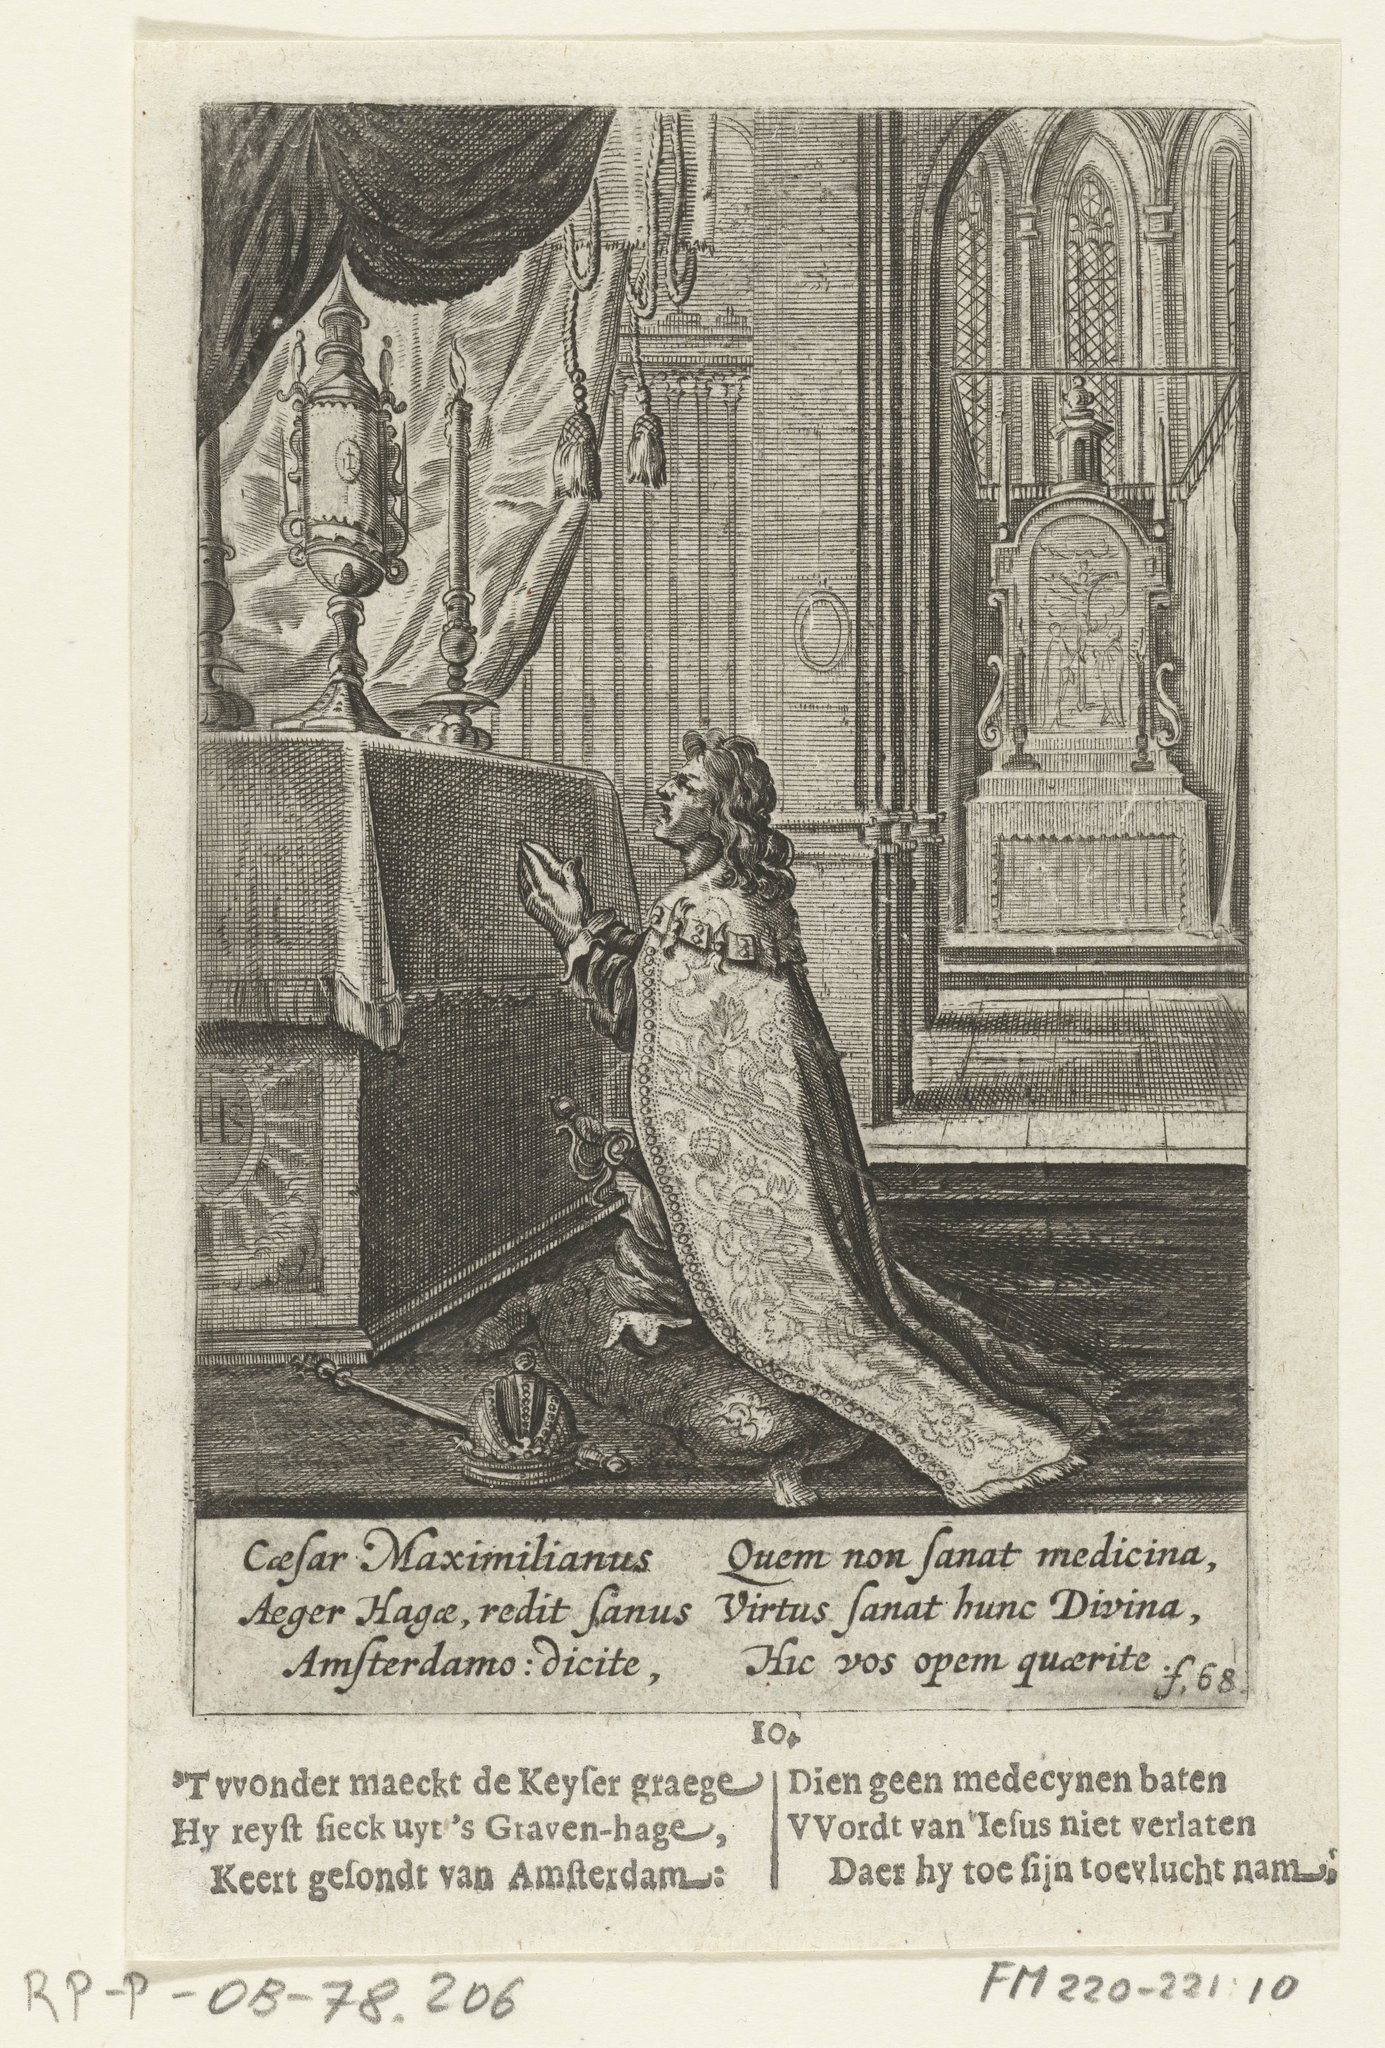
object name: print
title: Het Mirakel van Amsterdam (kopie), 1345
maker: Anonymous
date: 1639-1699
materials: paper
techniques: engraving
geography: low countries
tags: maximilian i (holy roman emperor), amsterdam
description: Keizer Maximiliaan I bidt geknield voor het H. Sacrament op het altaar en wordt weer gezond. Op de grond de keizerskroon en scepter. Prent nr. 10 uit de serie van 16 voorstellingen van Het Mirakel van Amsterdam, naar de gebeurtenissen op 15 maart 1345. Kopieën naar de reeks van Bolswert. Onder de voorstelling in de plaat gegraveerd een zesregelig vers in het Latijn, daaronder een zesregelig vers in boekdruk in het Nederlands.